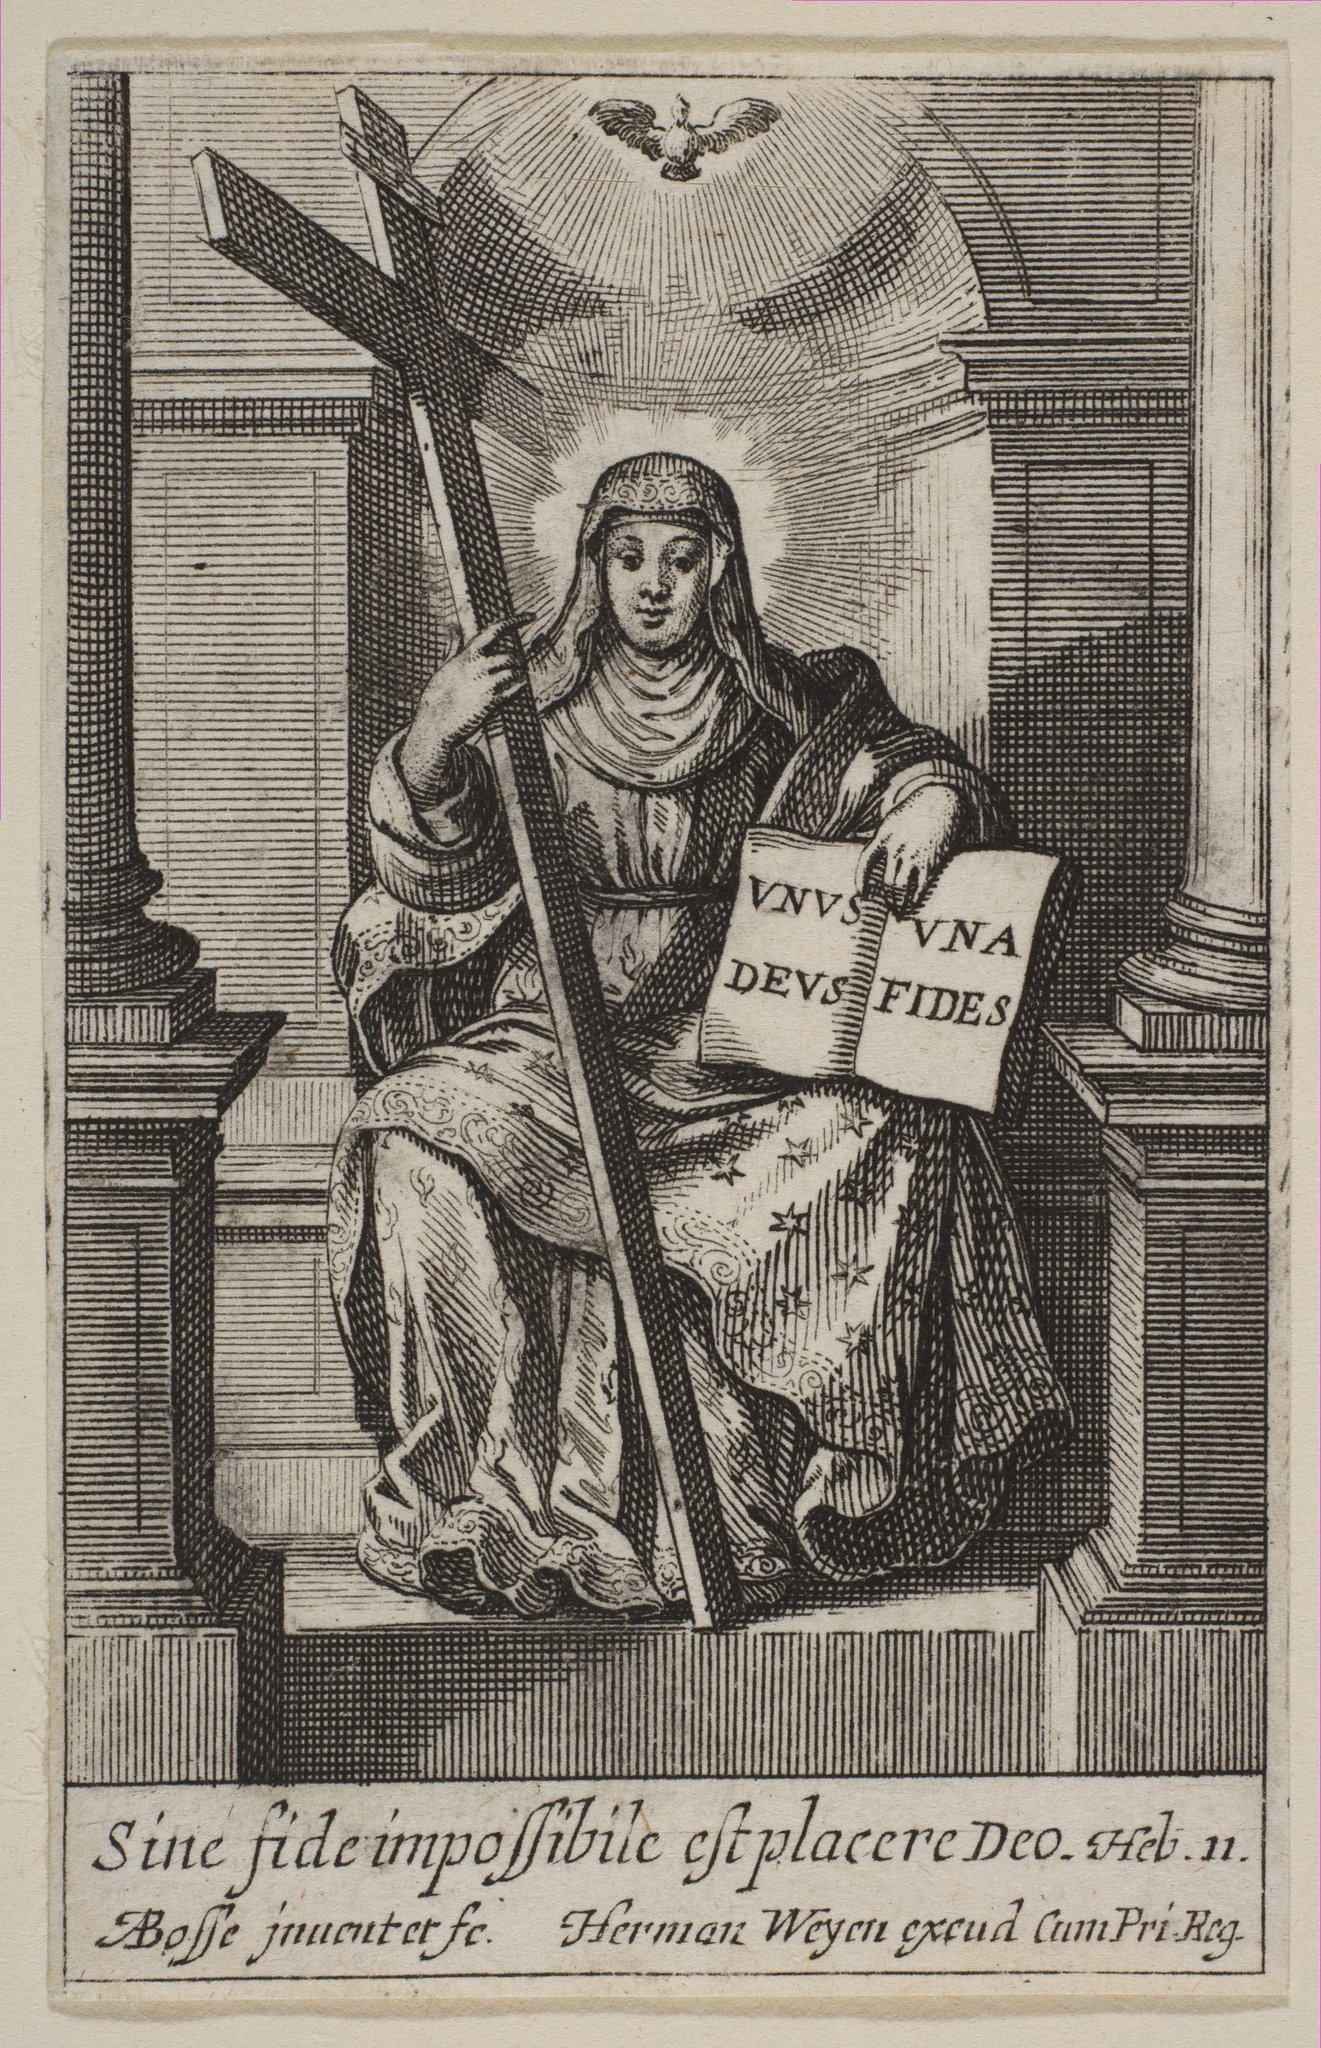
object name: print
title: Faith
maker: abraham bosse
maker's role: artist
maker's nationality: french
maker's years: 1602-1676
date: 1636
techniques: etching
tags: women,cross